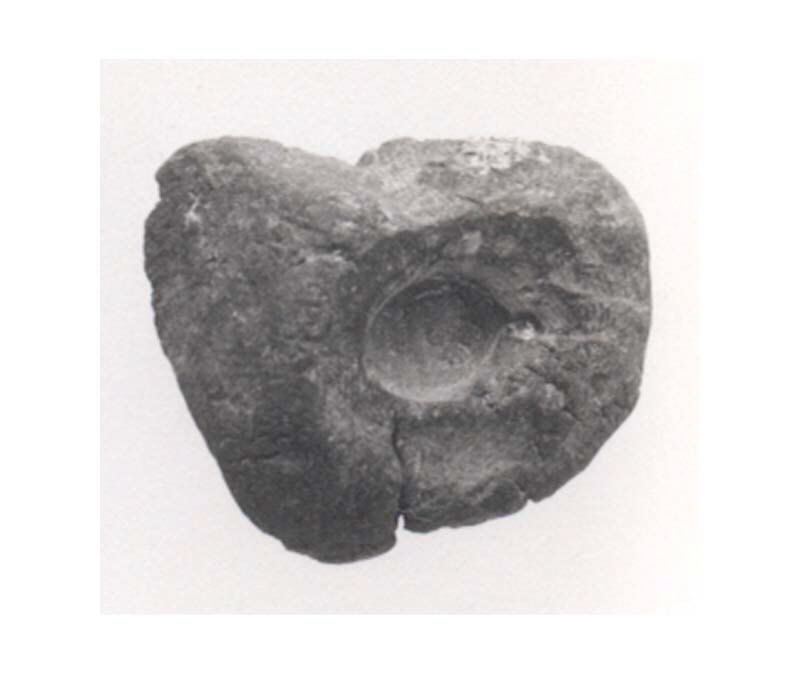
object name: sealing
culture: sasanian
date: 601-700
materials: clay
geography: iran